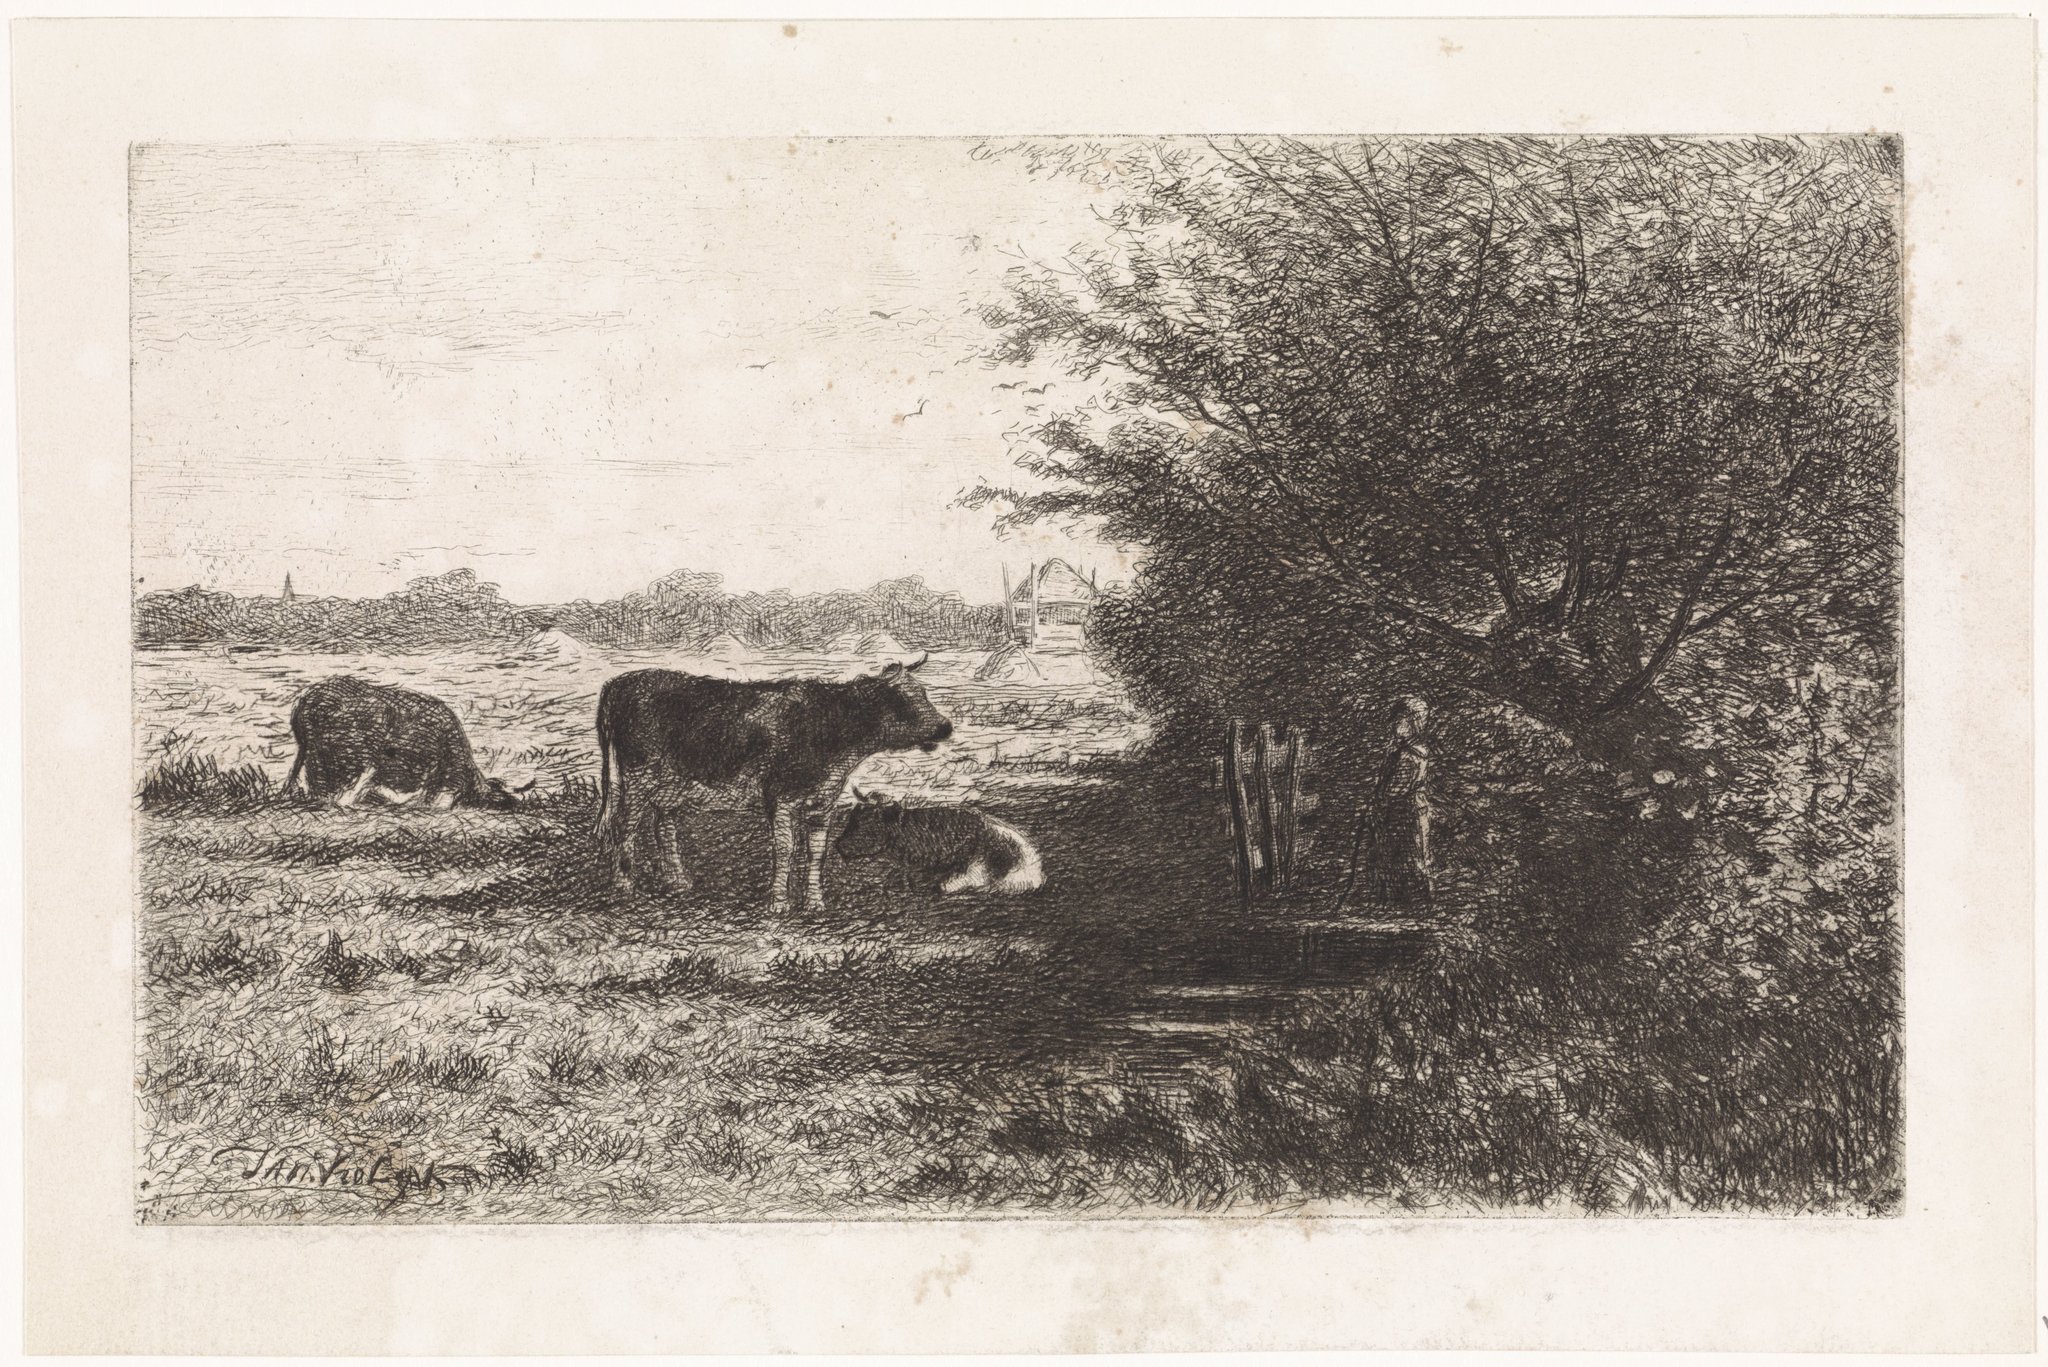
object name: print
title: Koeien in weiland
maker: jan vrolijk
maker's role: draughtsman, painter, print maker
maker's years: 1846-1894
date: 1860-1894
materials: paper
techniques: etching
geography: the hague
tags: cow, hay-stack, trees: willow, pond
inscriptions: collector's mark: Lugt 2228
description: Koeien staan in een weiland bij een vijver. Een kind bij het hek kijkt naar hen. Op de achtergrond een hooischuur.